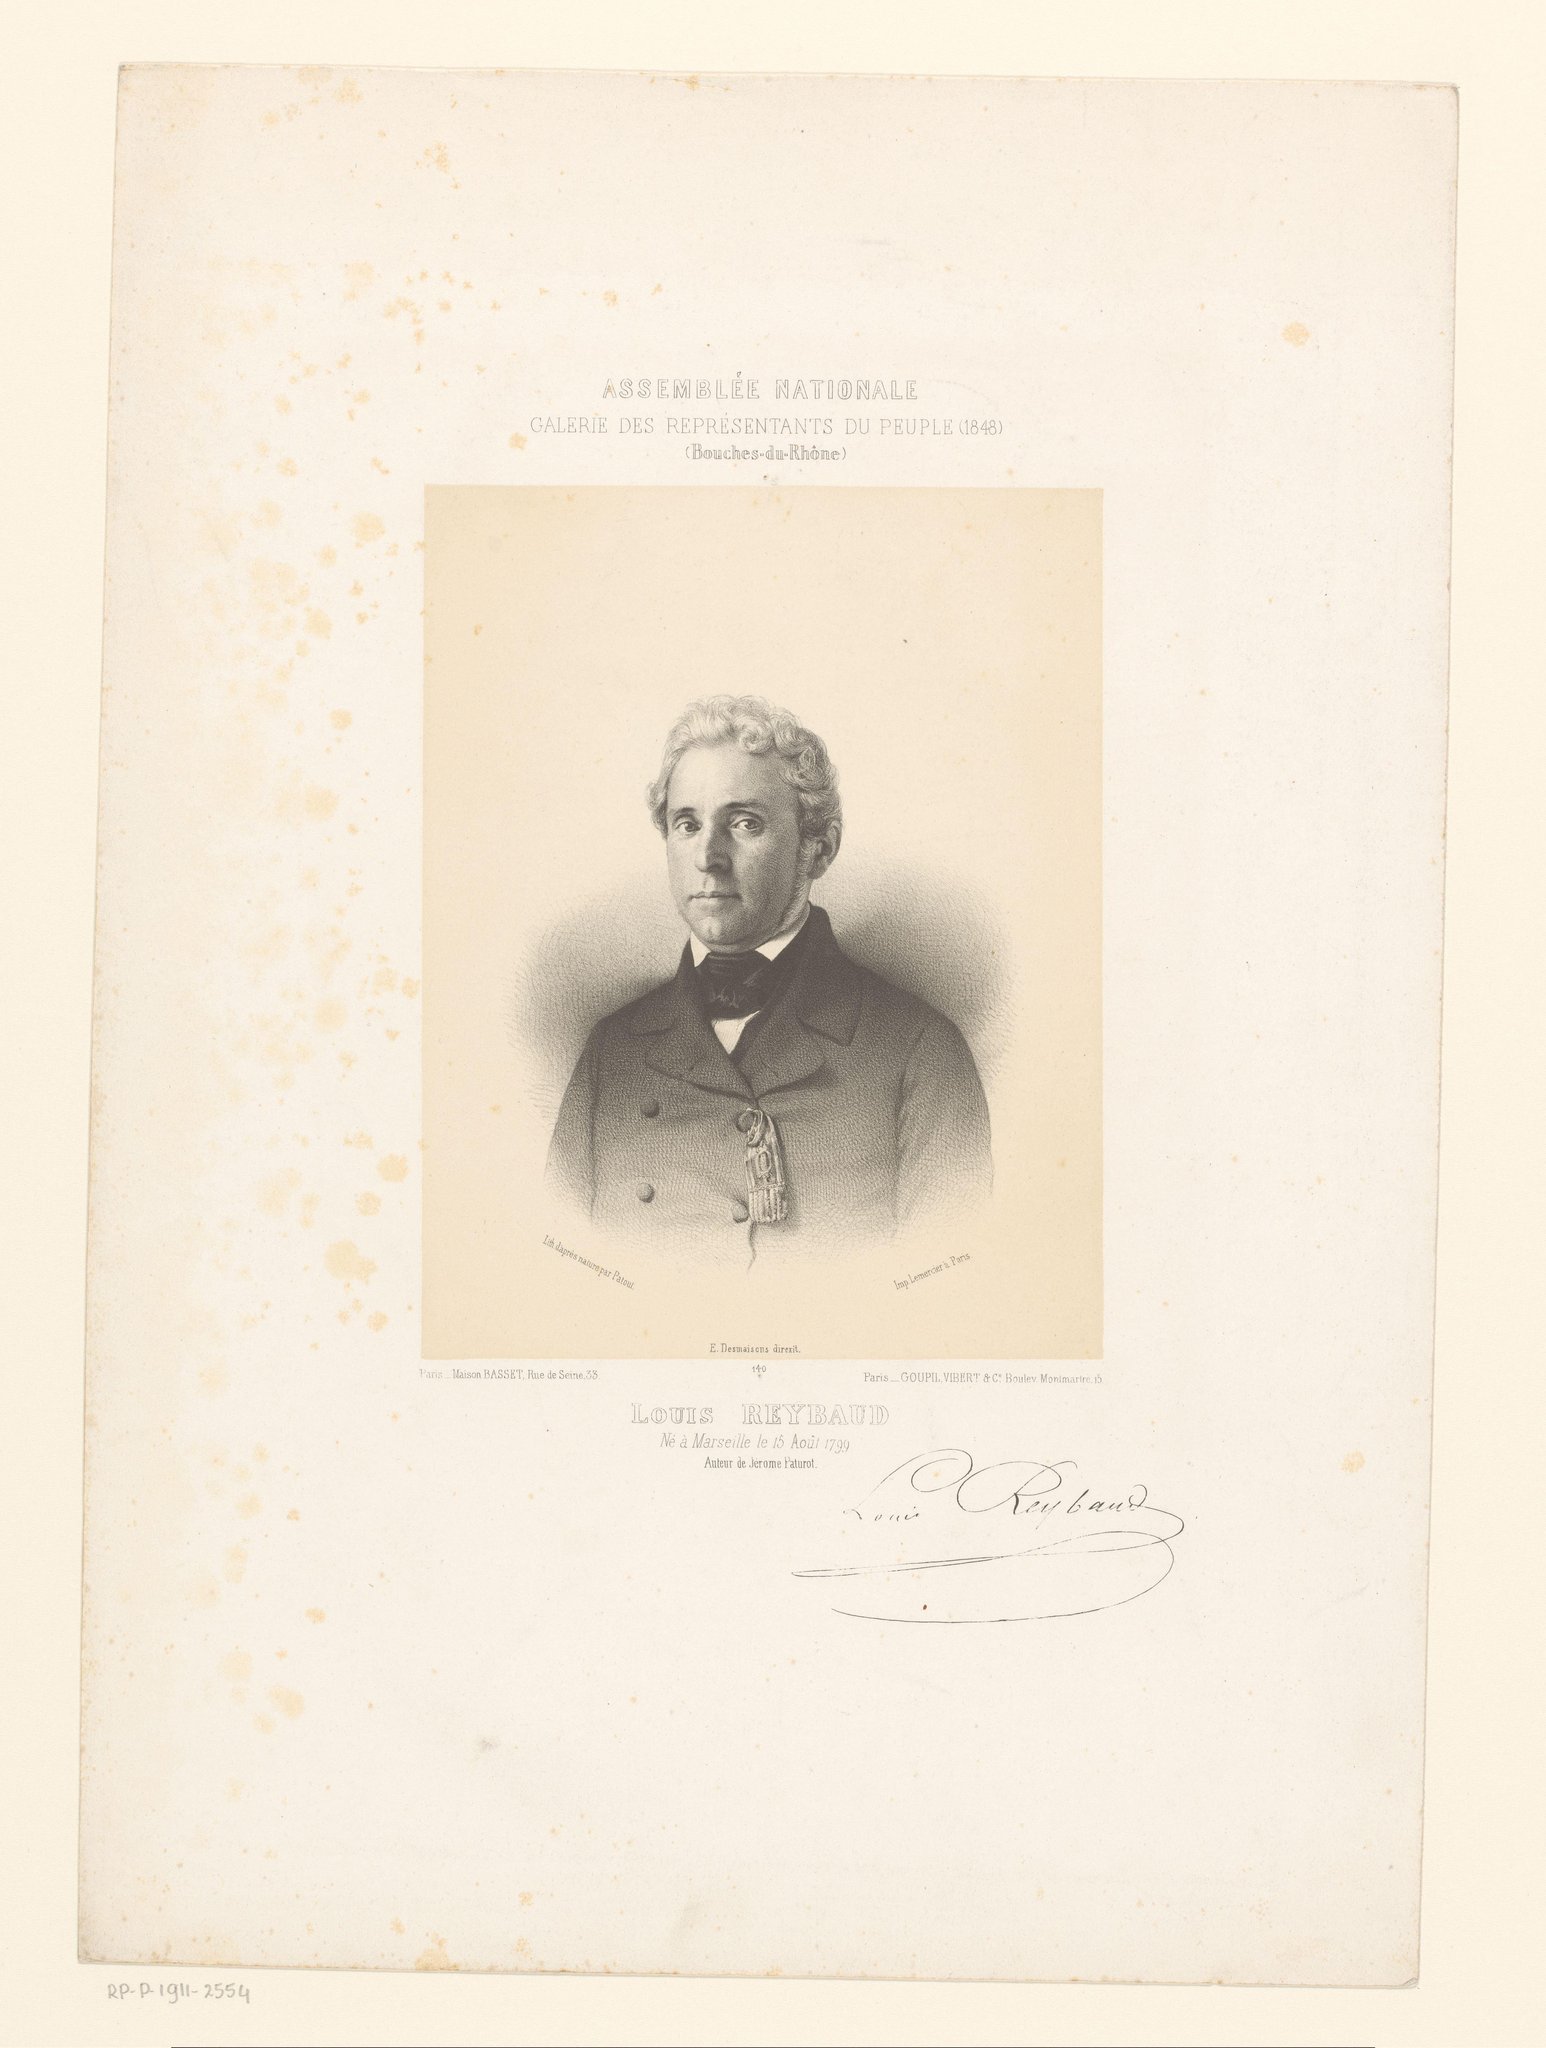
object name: print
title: Assemblée Nationale. Galerie des représentants du peuple (1848)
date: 1848-1849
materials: paper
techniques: tone lithography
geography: paris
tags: marie roch louis reybaud, historical persons, politician, e.g. party leader, writer, poet, author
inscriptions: collector's mark: Lugt 2228